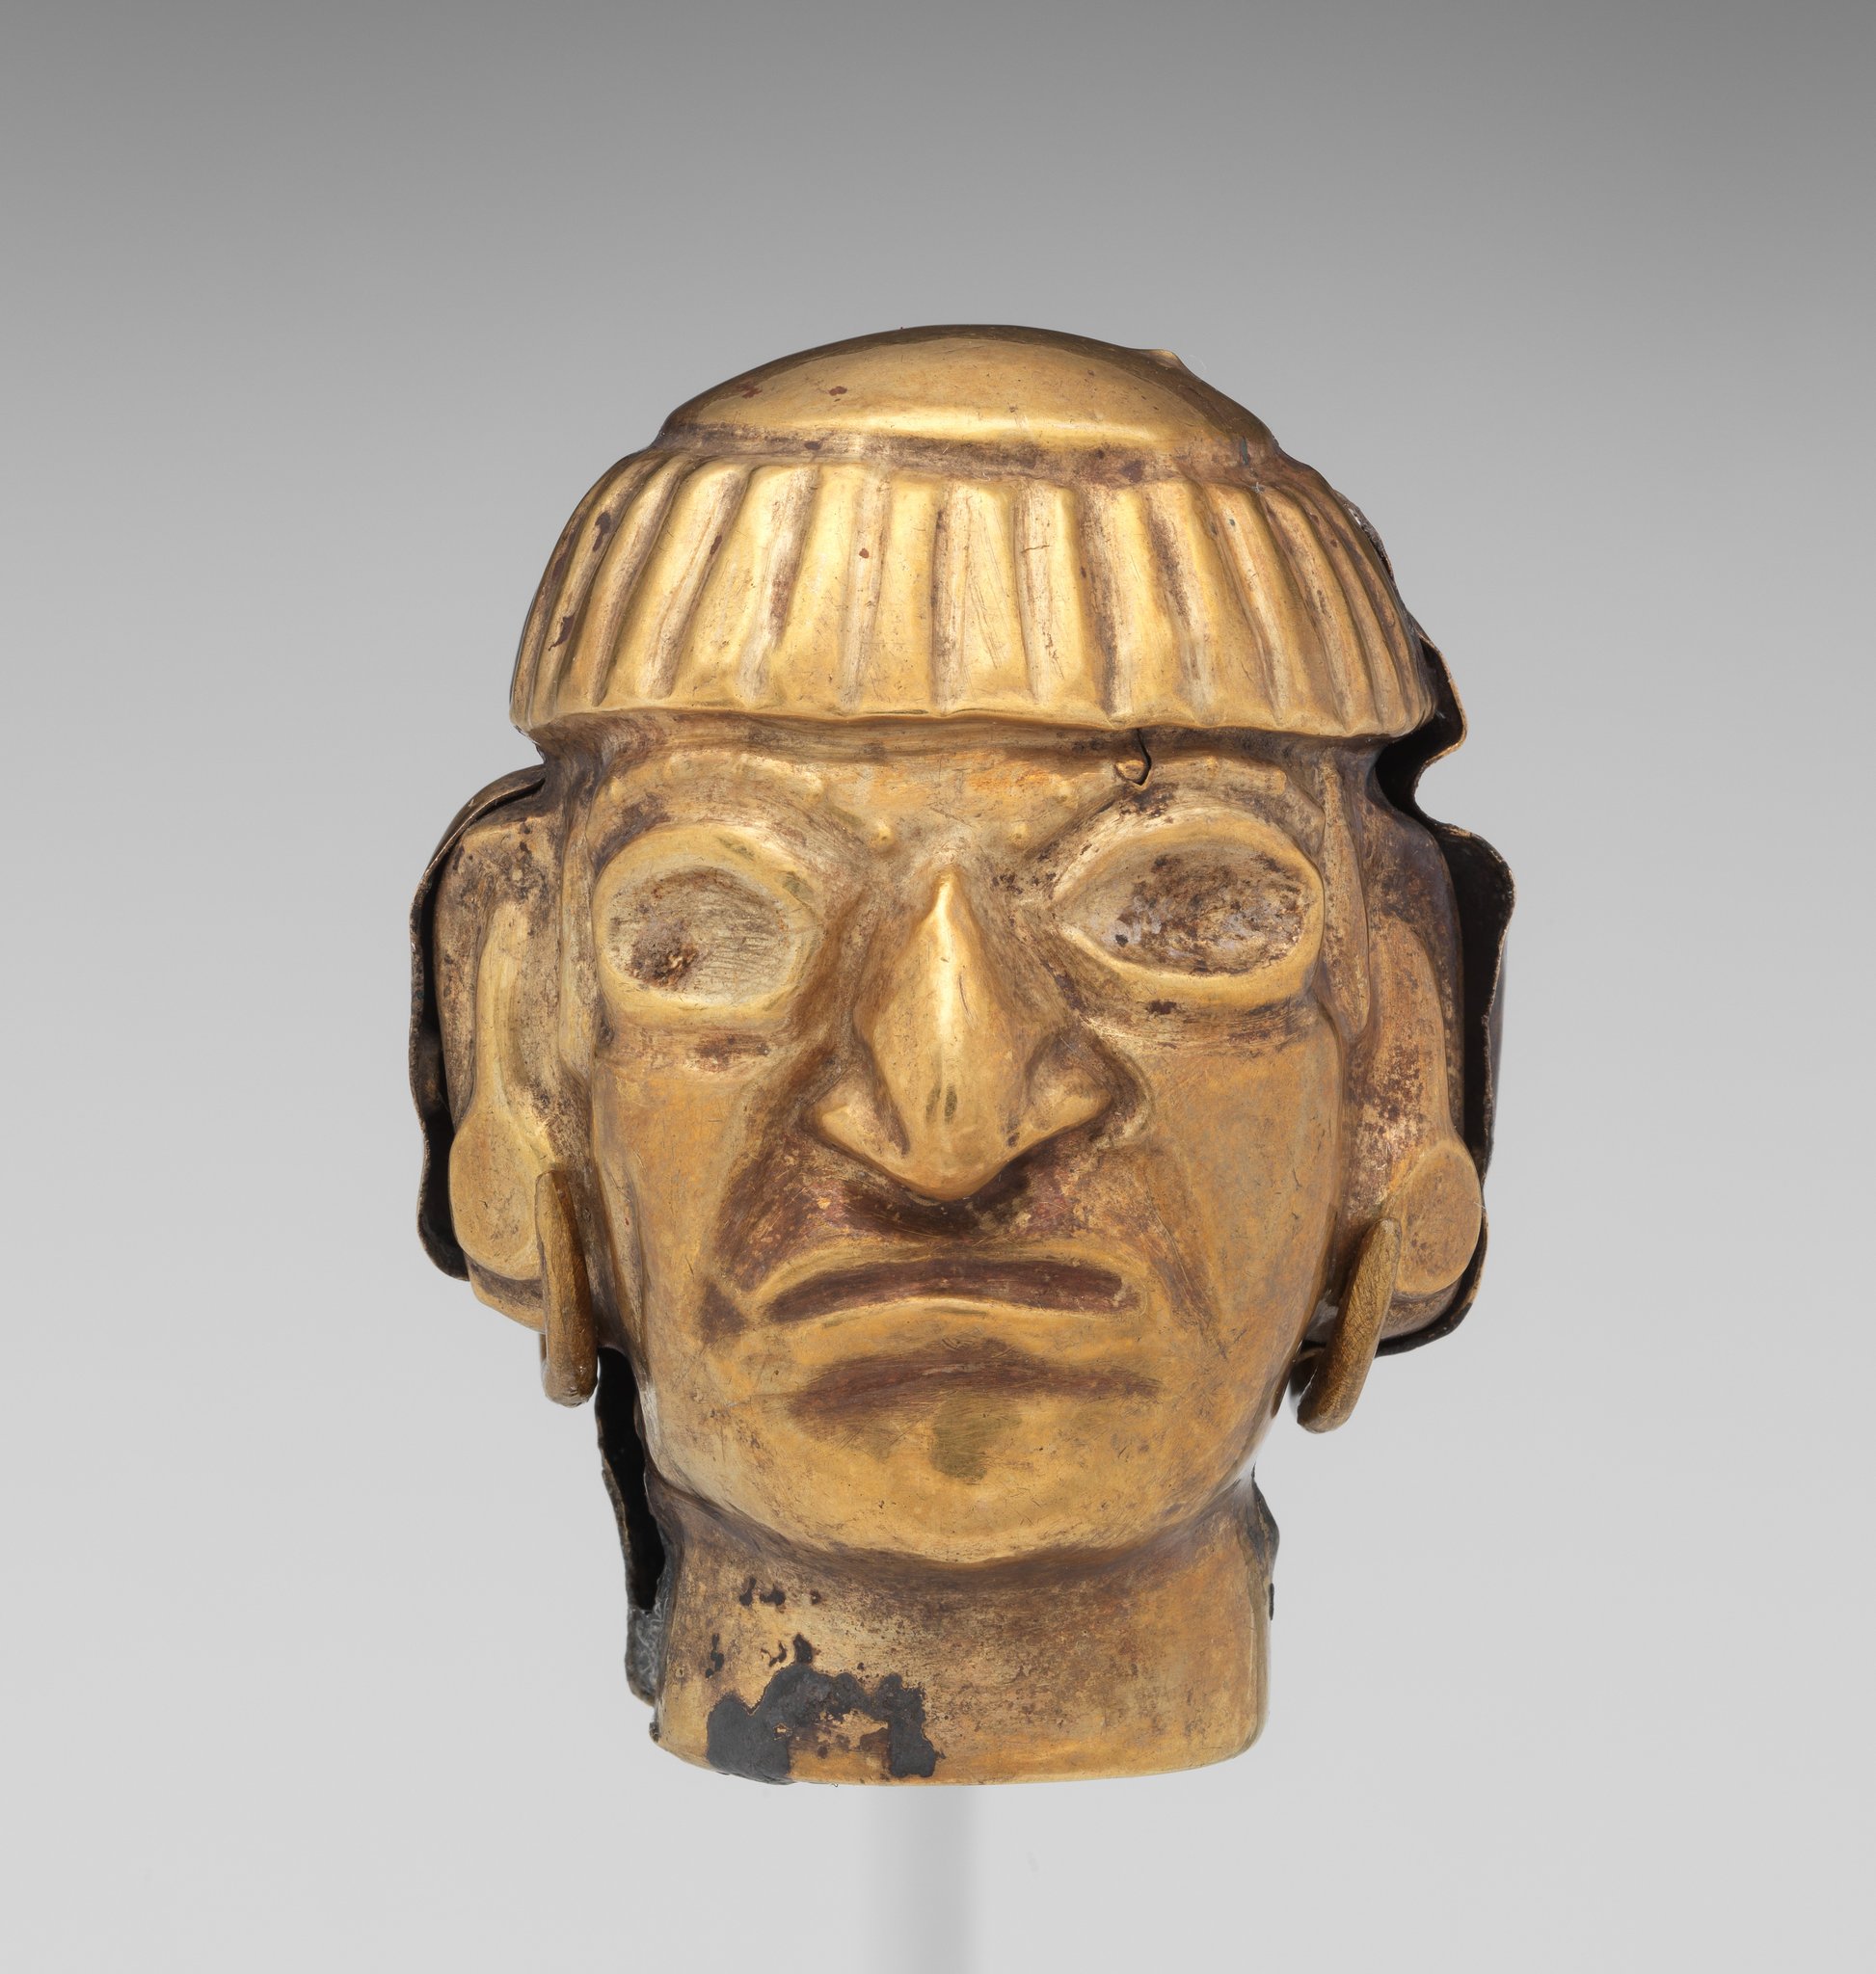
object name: bead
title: Head-shaped bead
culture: moche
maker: moche artist(s)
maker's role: artist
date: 201-700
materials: gold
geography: peru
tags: heads